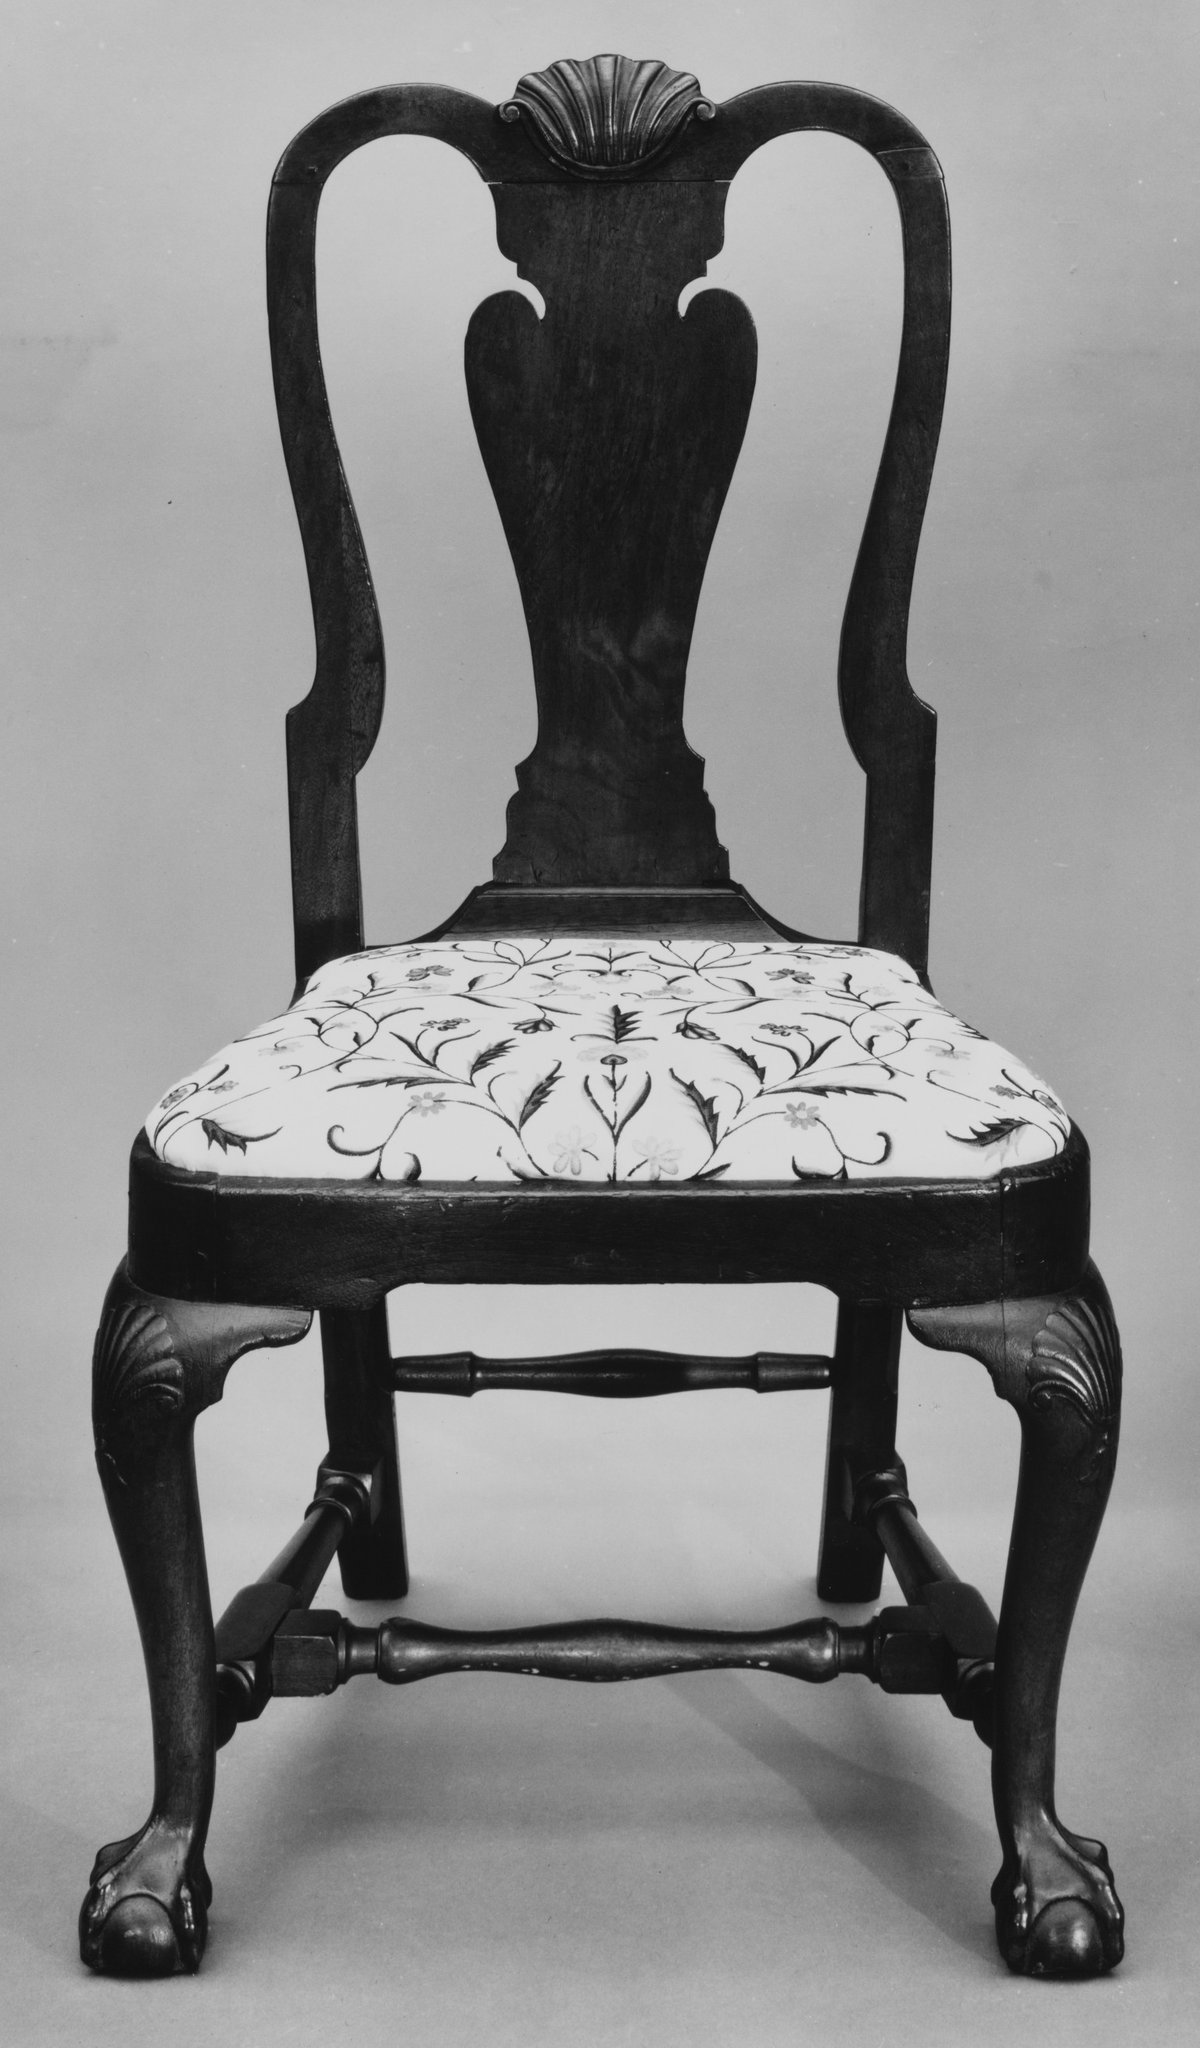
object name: side chair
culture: american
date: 1730-1750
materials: wood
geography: united states